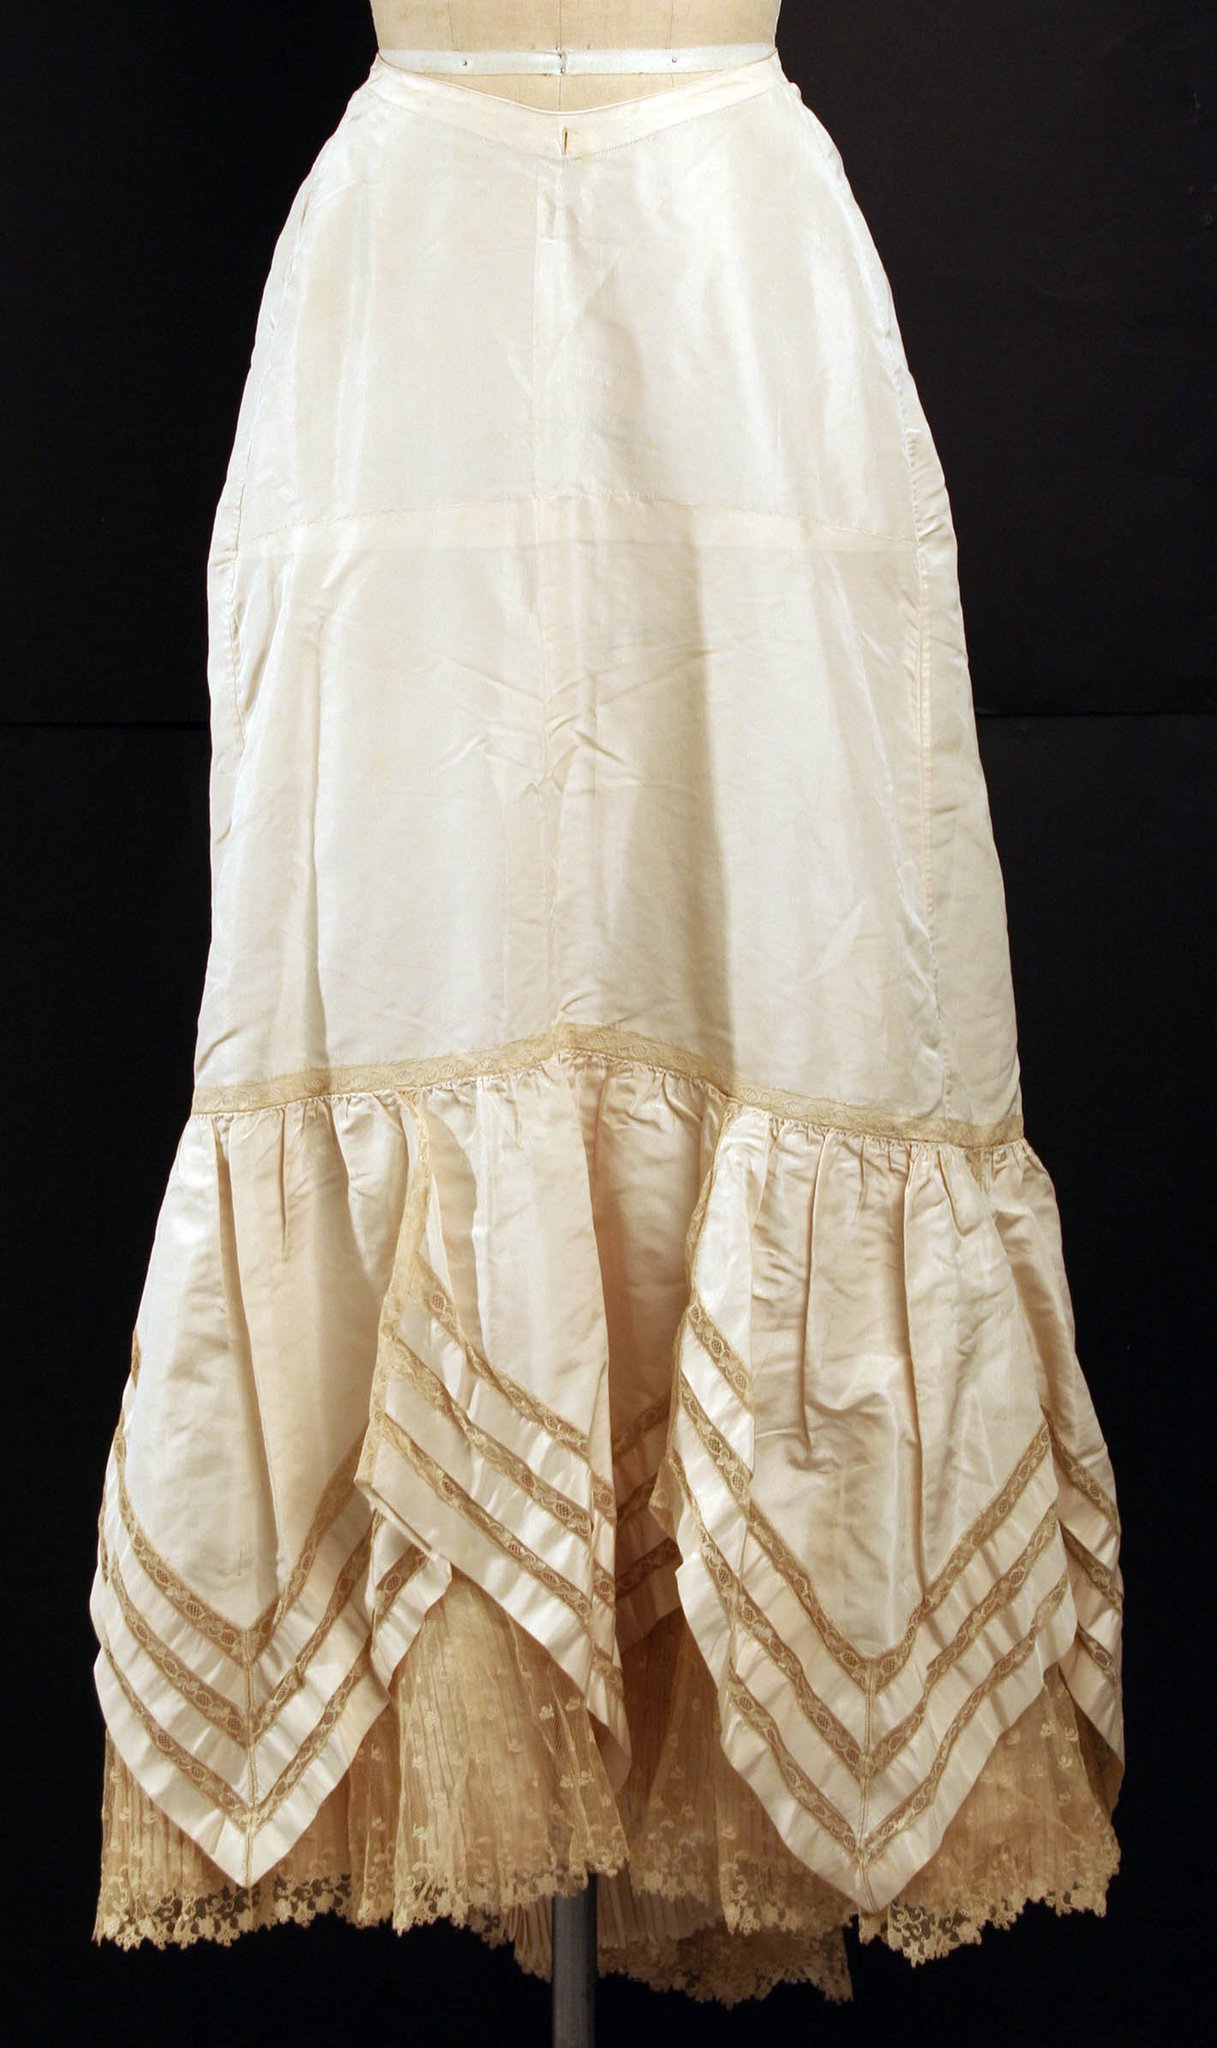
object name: petticoat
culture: french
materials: silk